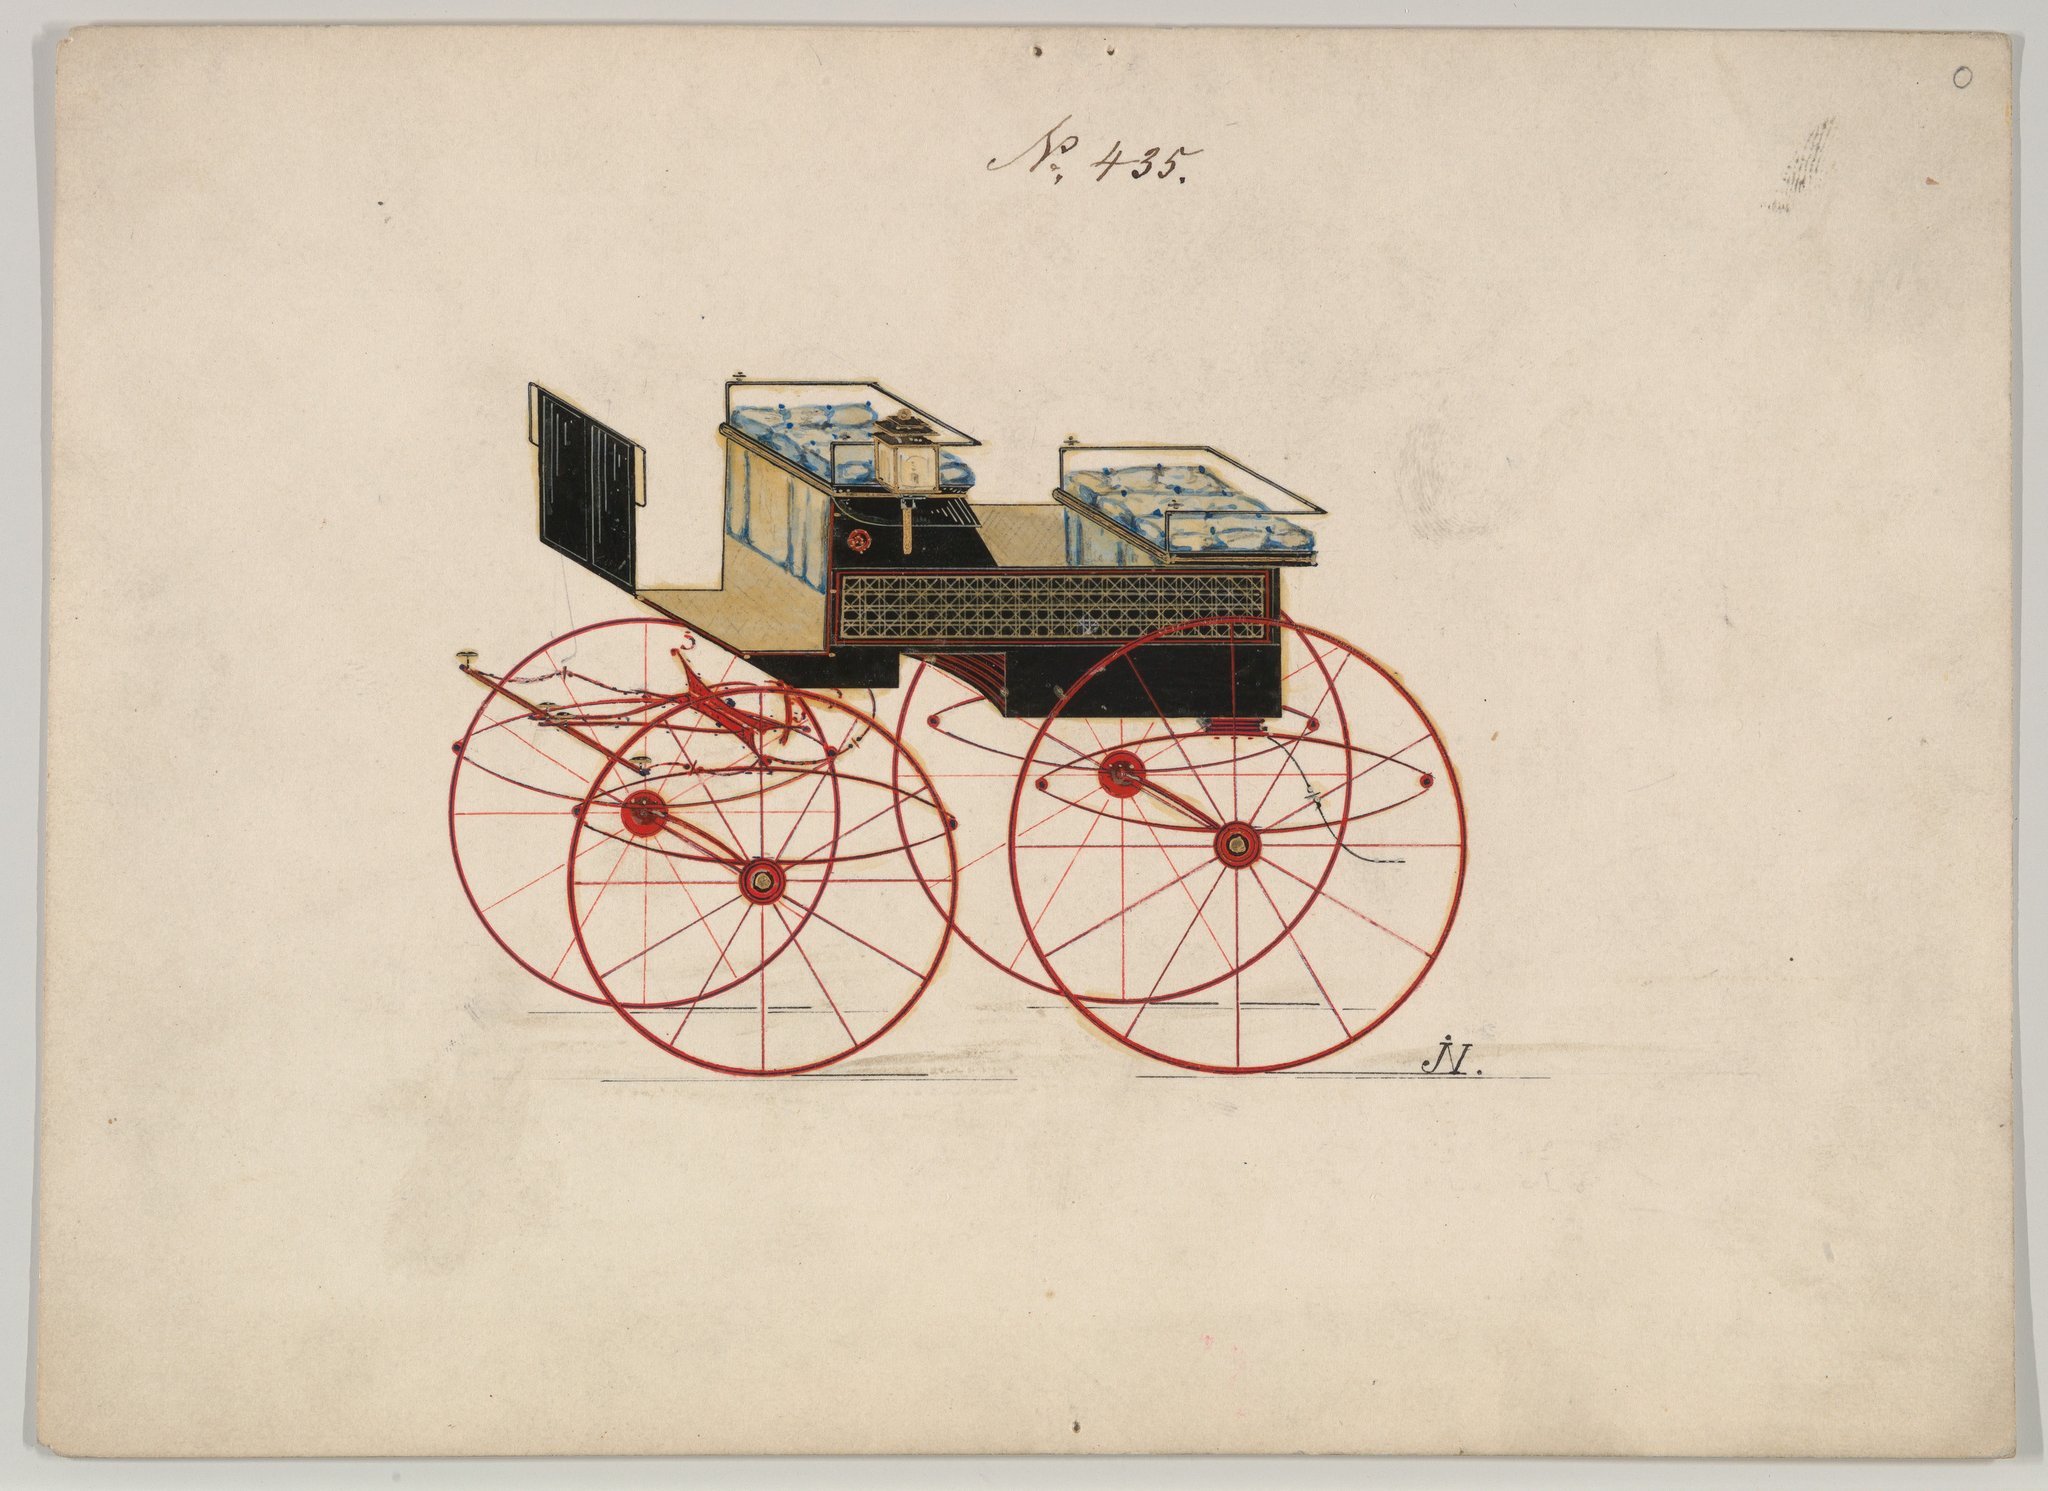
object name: drawing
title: Dog Cart Phaeton #435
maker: brewster & co.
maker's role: manufacturer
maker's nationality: american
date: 1850-1870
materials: gouache, gum arabic, ink, watercolor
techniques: pen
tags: carriages